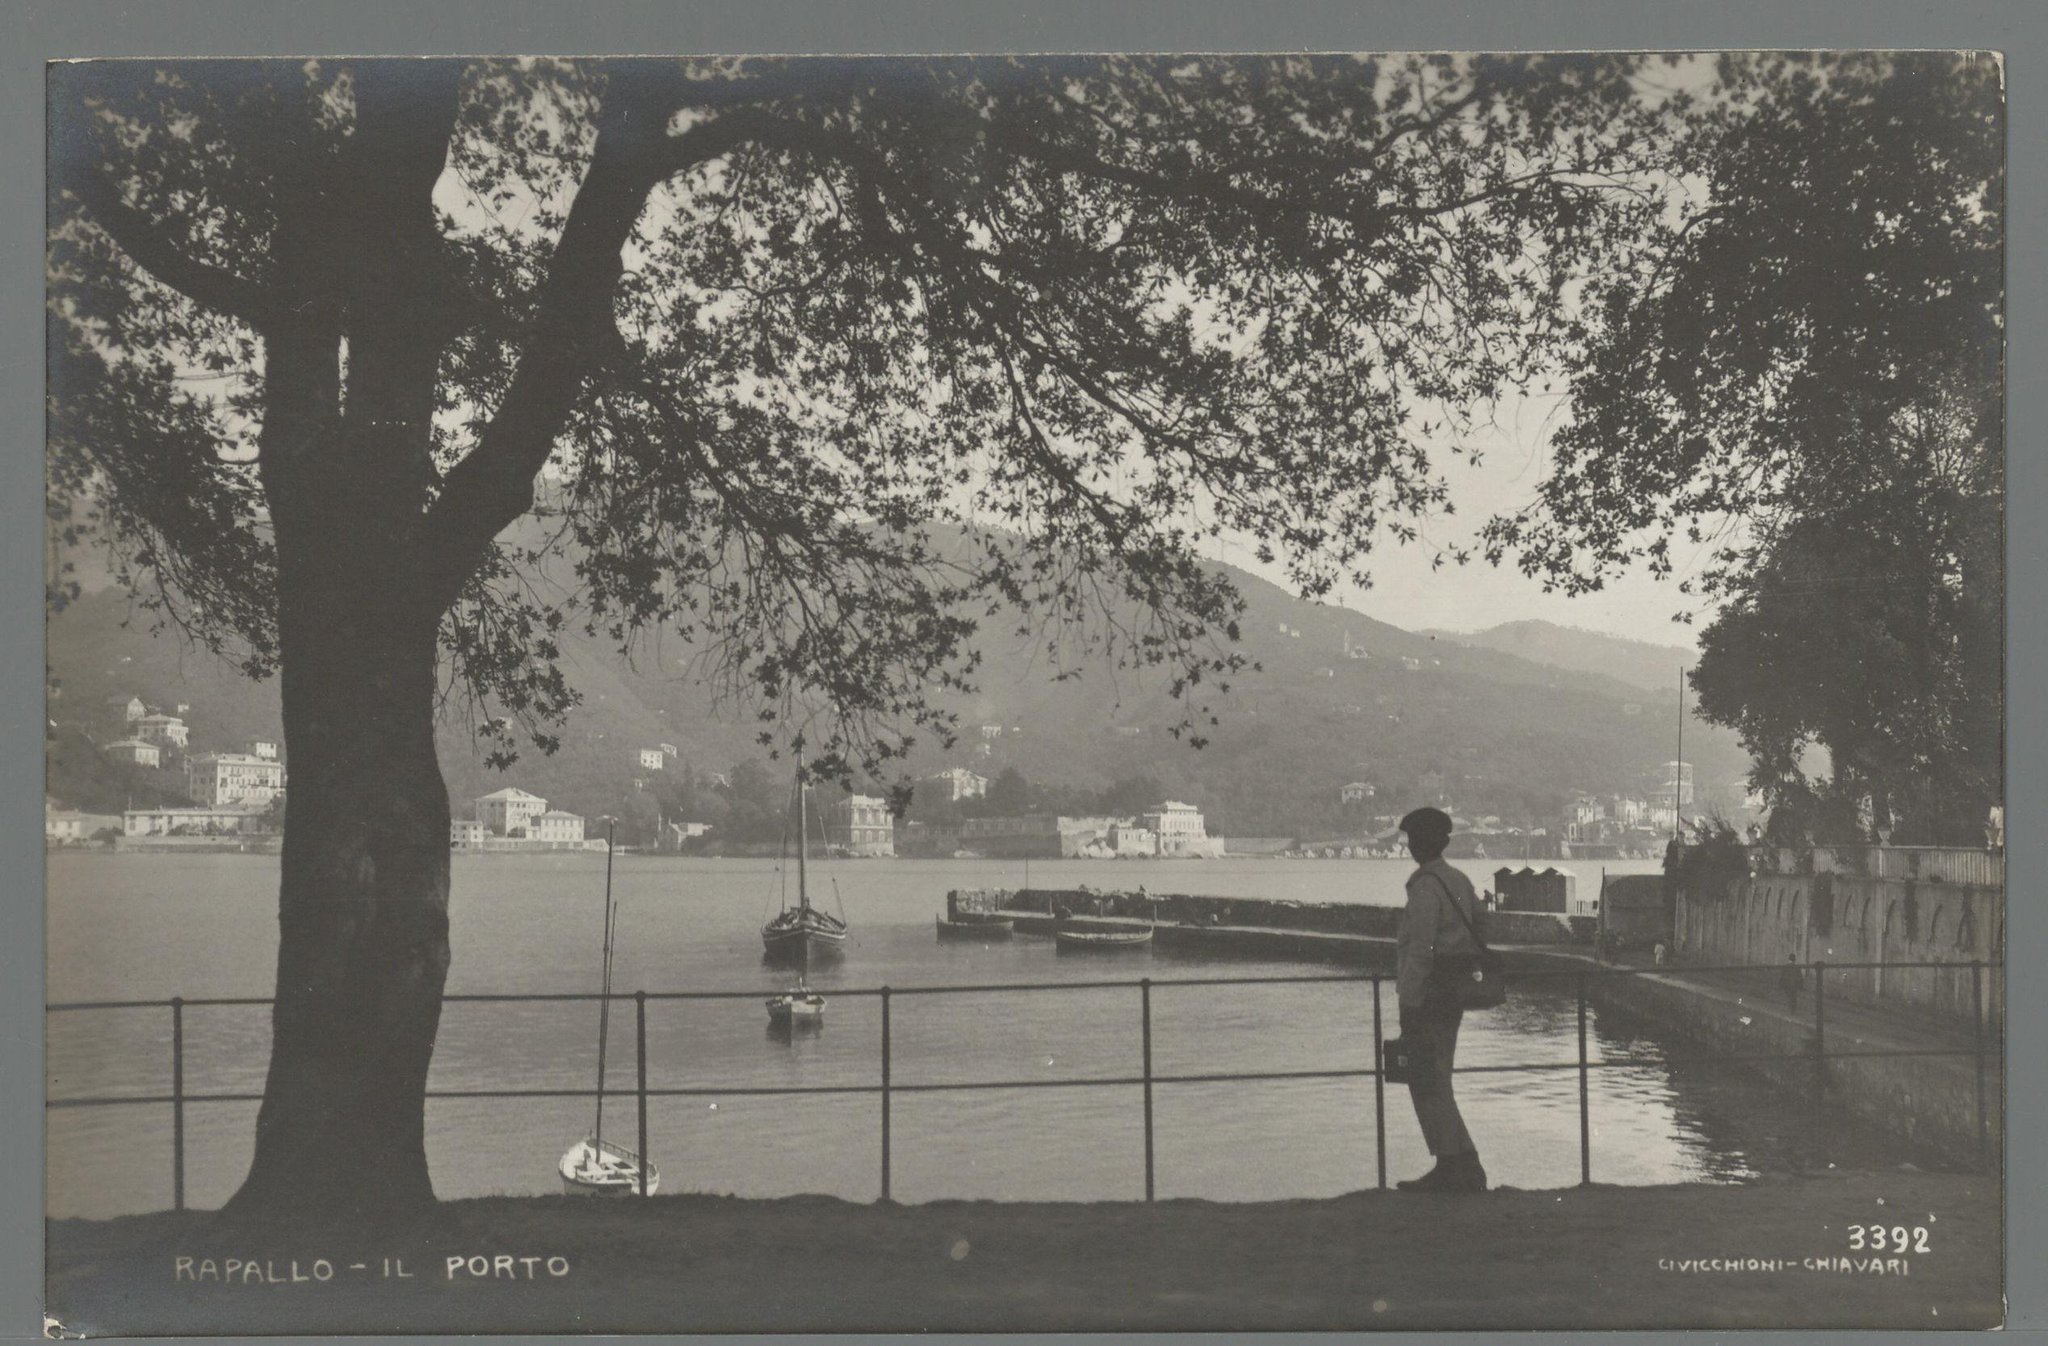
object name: photograph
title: Rappallo. Il porto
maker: Anonymous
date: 1906-1909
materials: photographic support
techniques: photography, writing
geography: chiavari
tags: harbour, city-view, and landscape with man-made constructions (+ city(-scape) with figures, staffage)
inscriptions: mark